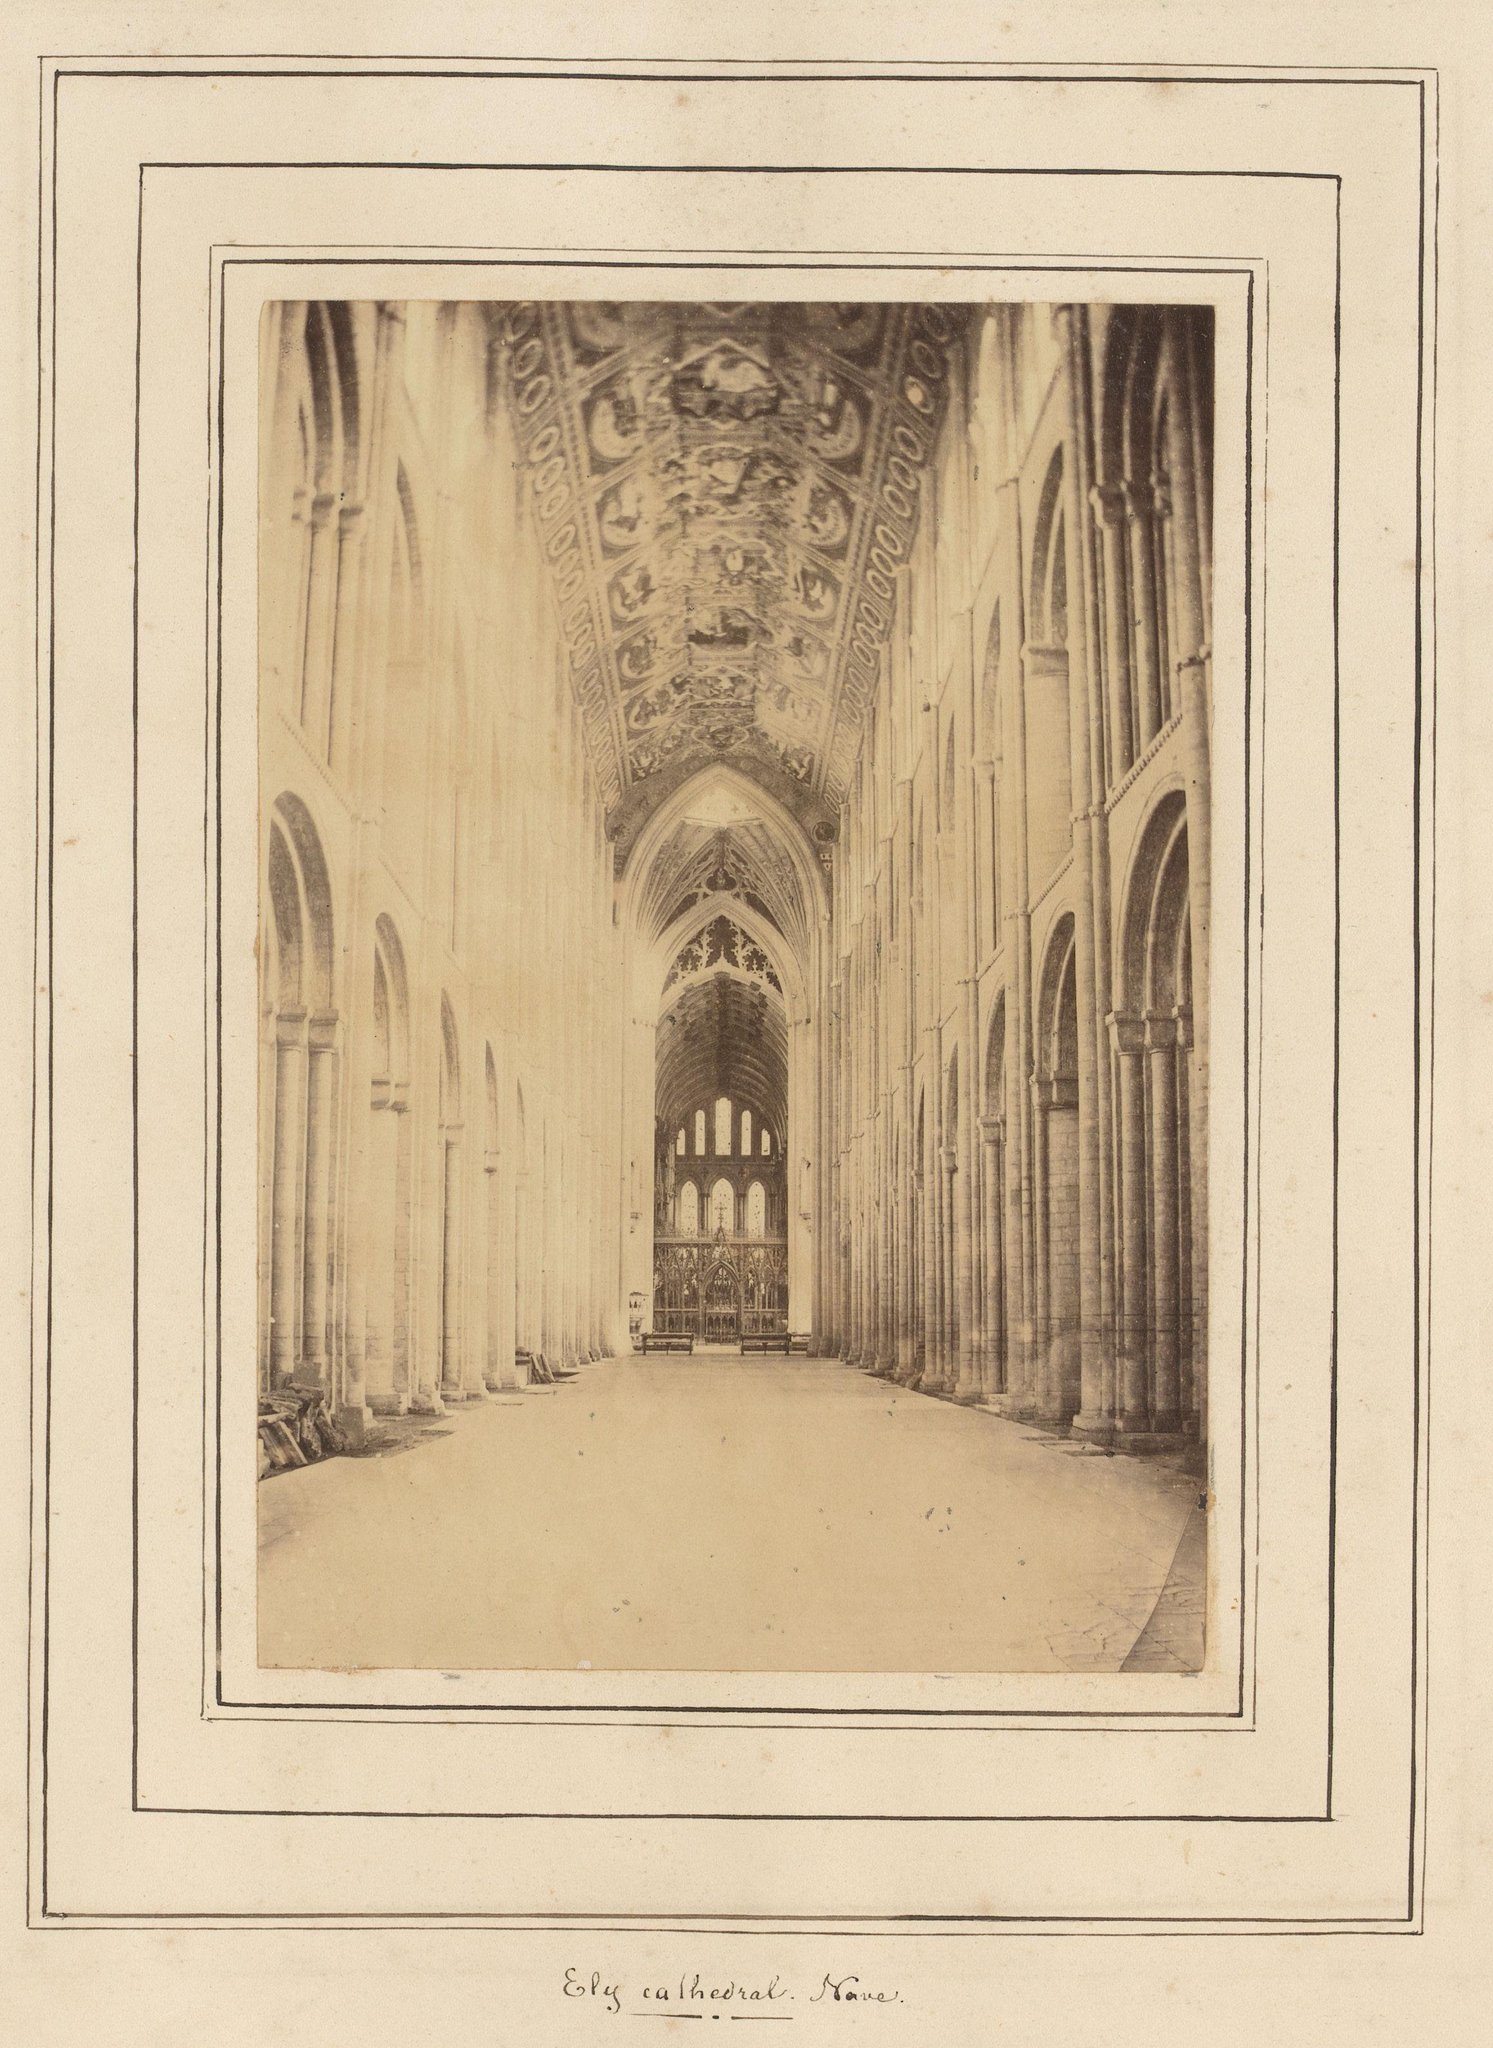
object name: album leaf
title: Ely cathedral. Nave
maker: Anonymous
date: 1865-1890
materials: paper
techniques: albumen print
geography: ely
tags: parts of church interior: nave